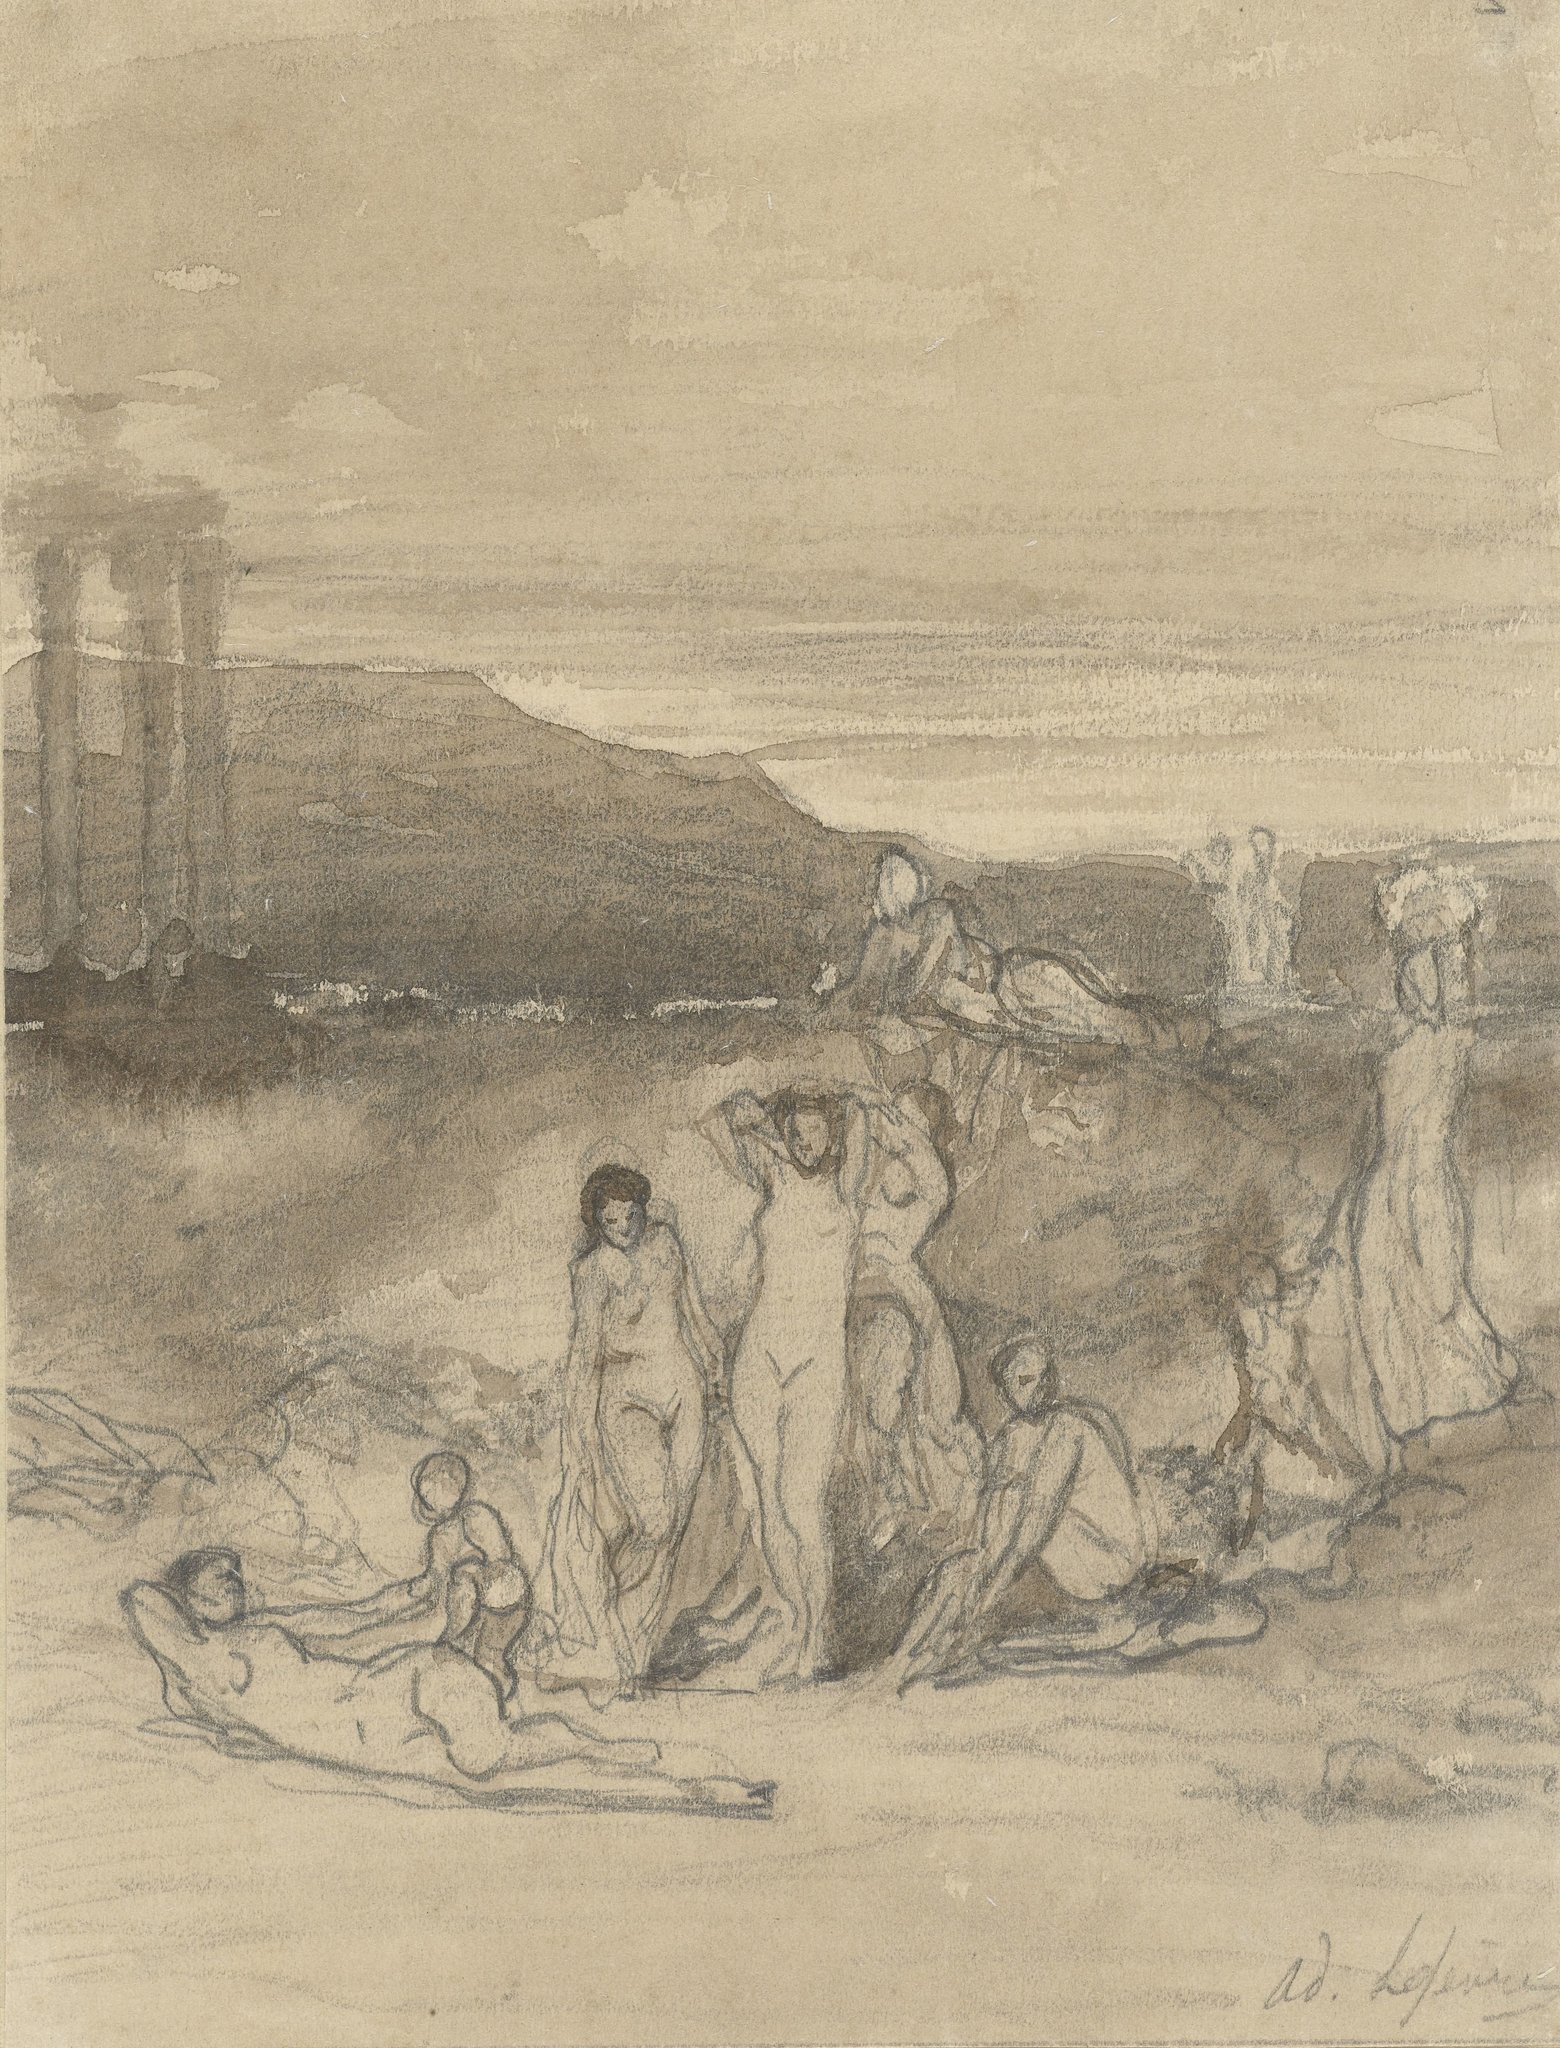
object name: drawing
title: Klassiek landschap met liggende, staande en zittende naaktfiguren en een tempelruïne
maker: adolphe rené lefèvre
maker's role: draughtsman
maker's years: 1834-1868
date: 1844-1868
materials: paper, pencil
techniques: brush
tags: landscape with ruins, public baths - aa - in the open air